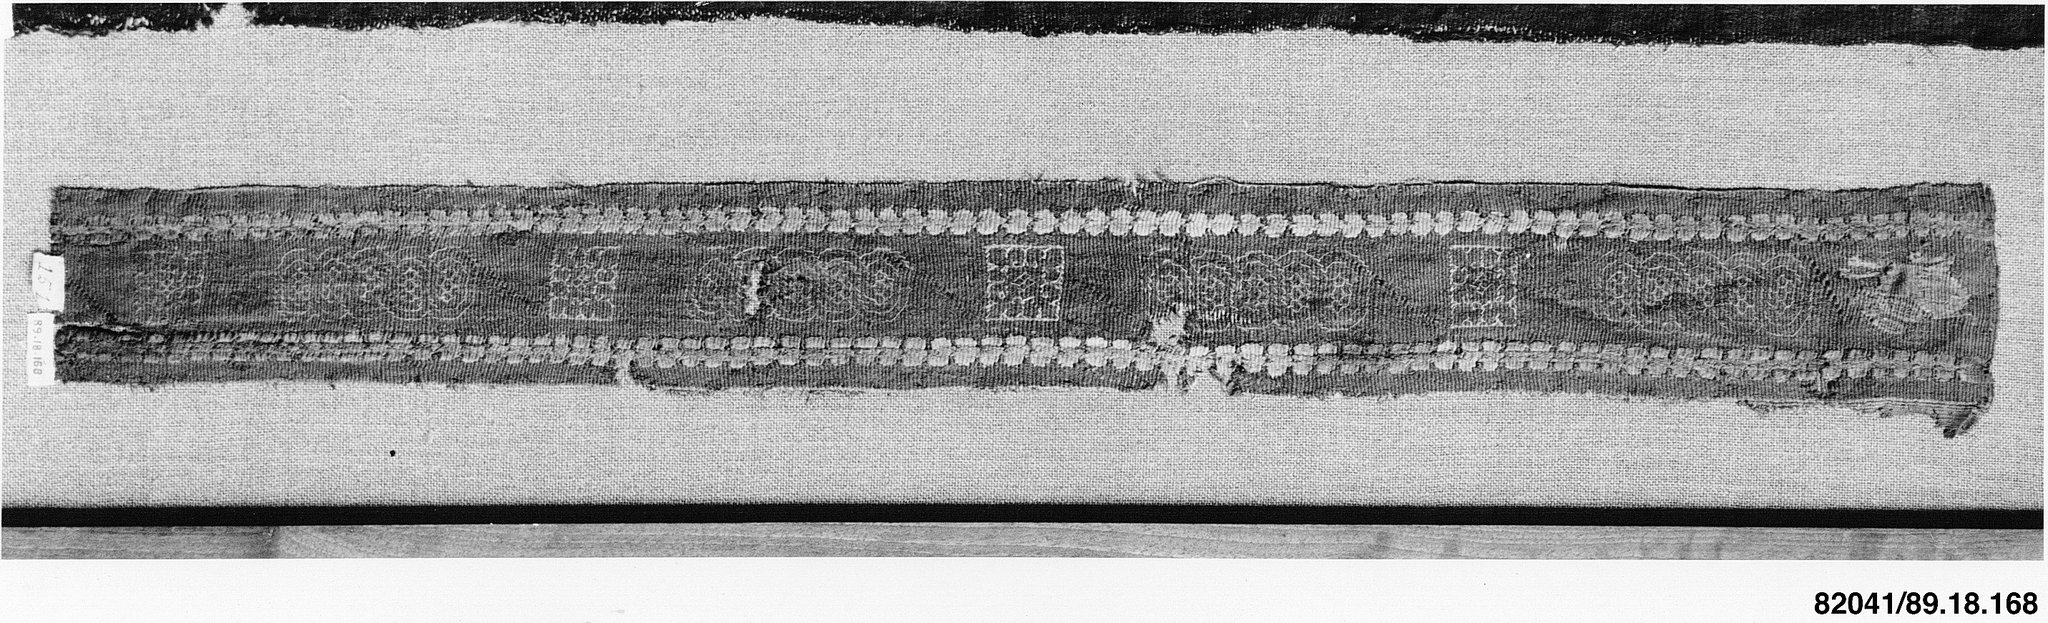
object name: textile fragment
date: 201-400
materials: linen, wool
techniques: weave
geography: egypt